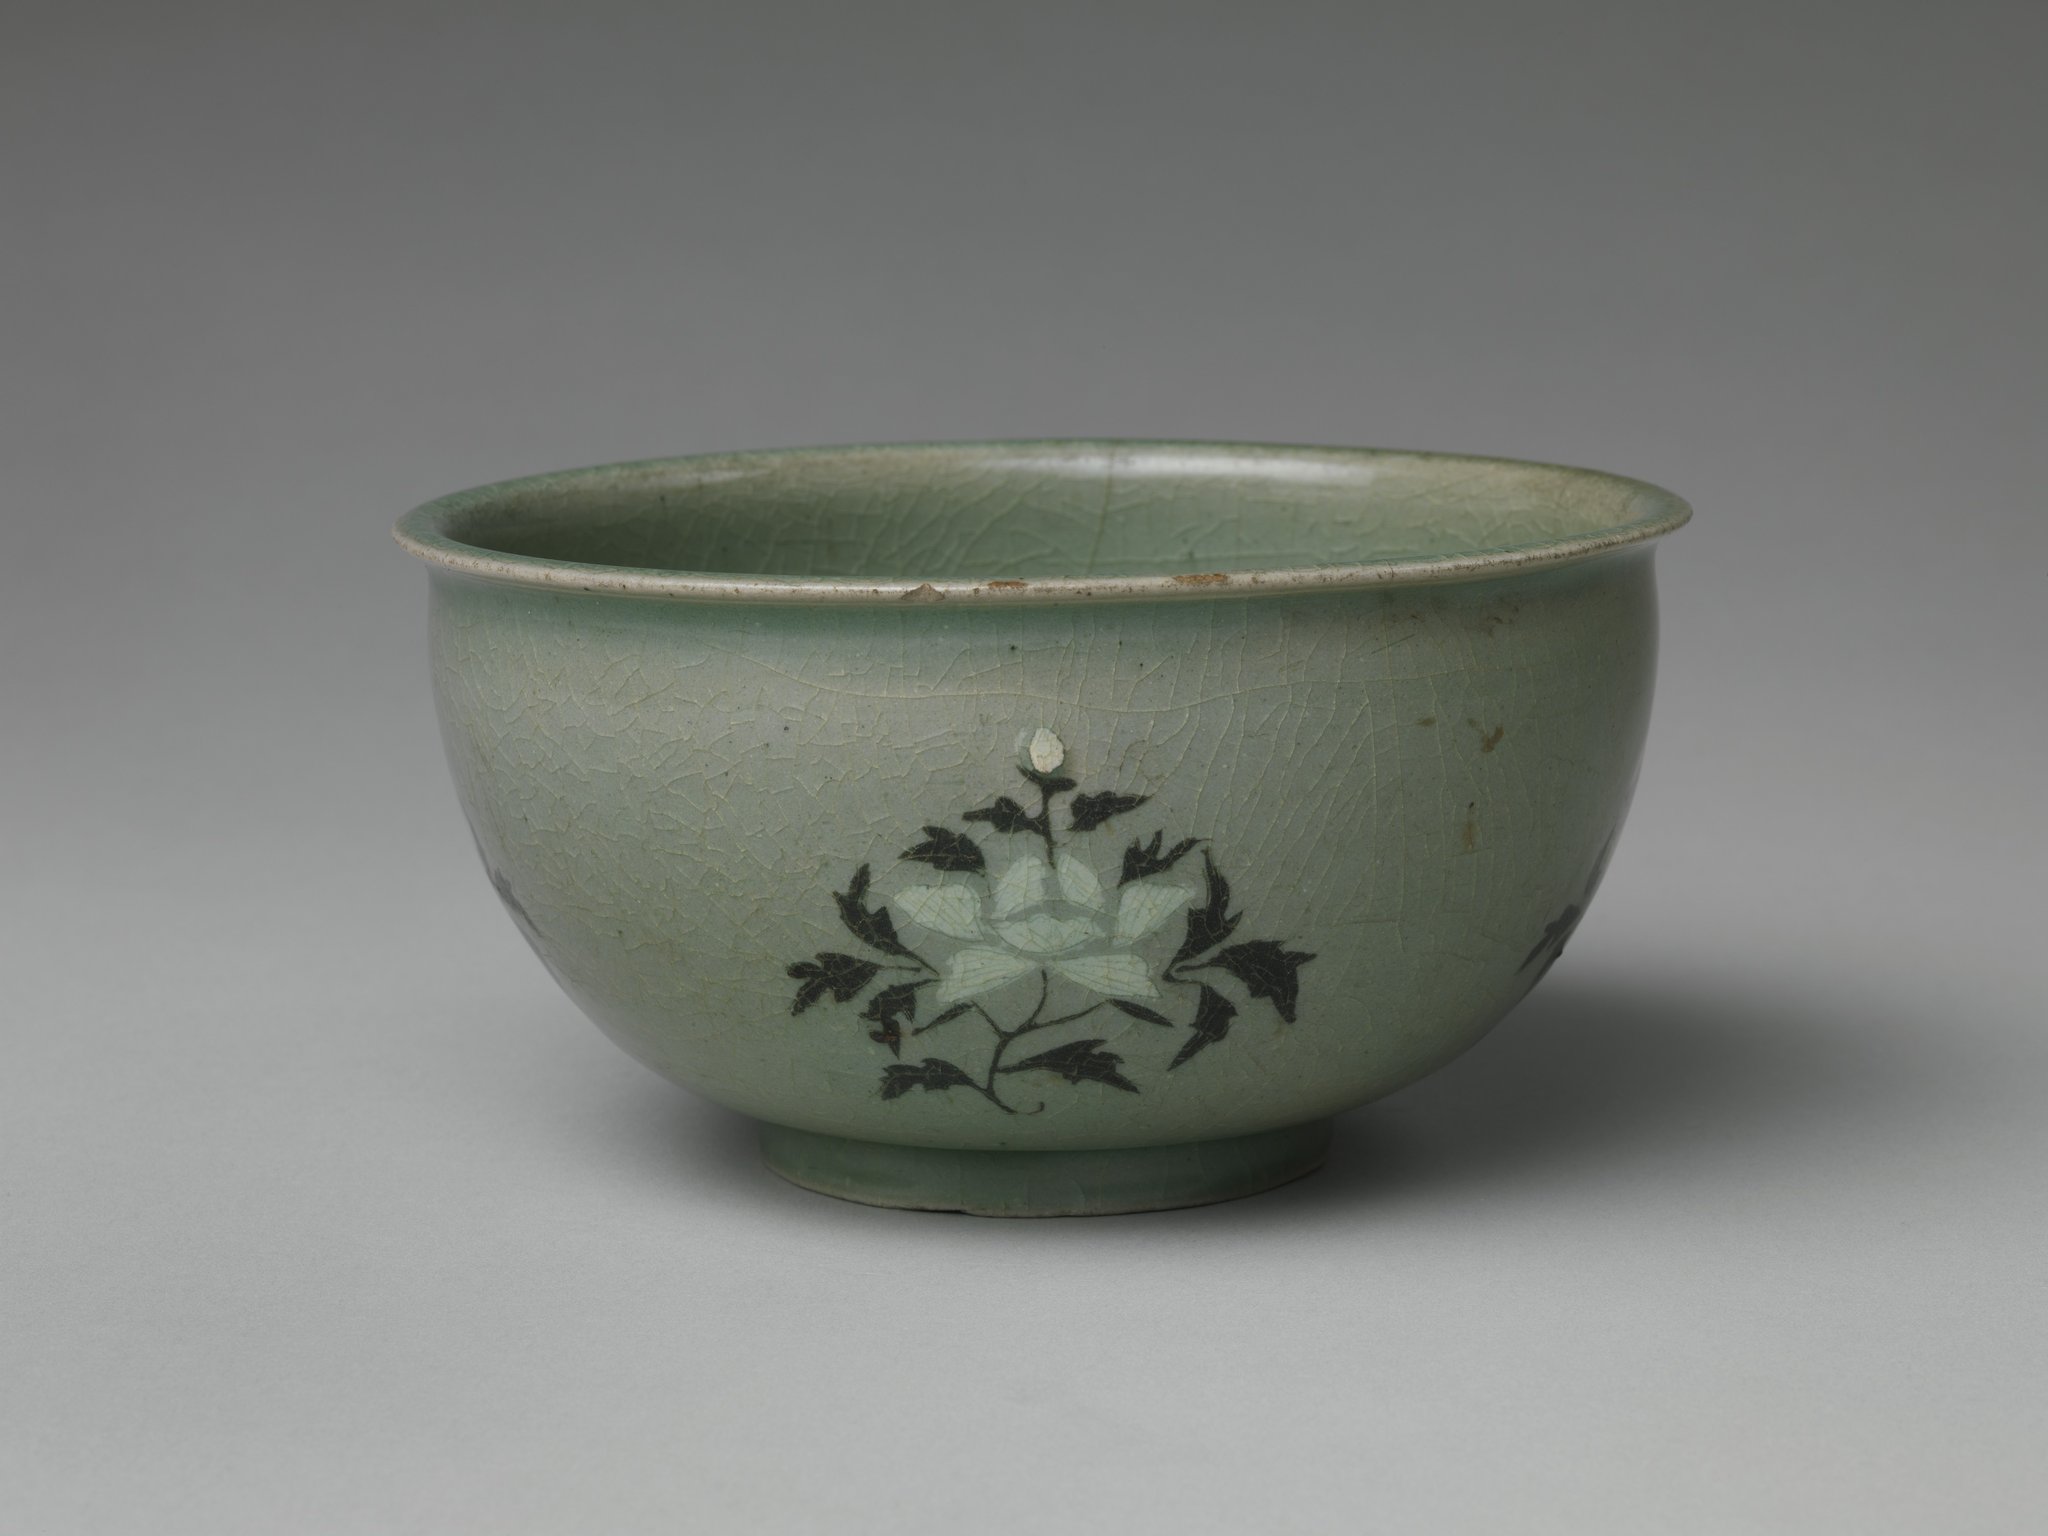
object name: basin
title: Basin decorated with peonies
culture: korean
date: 1151-1200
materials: ceramic glaze, glaze, stoneware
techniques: inlay